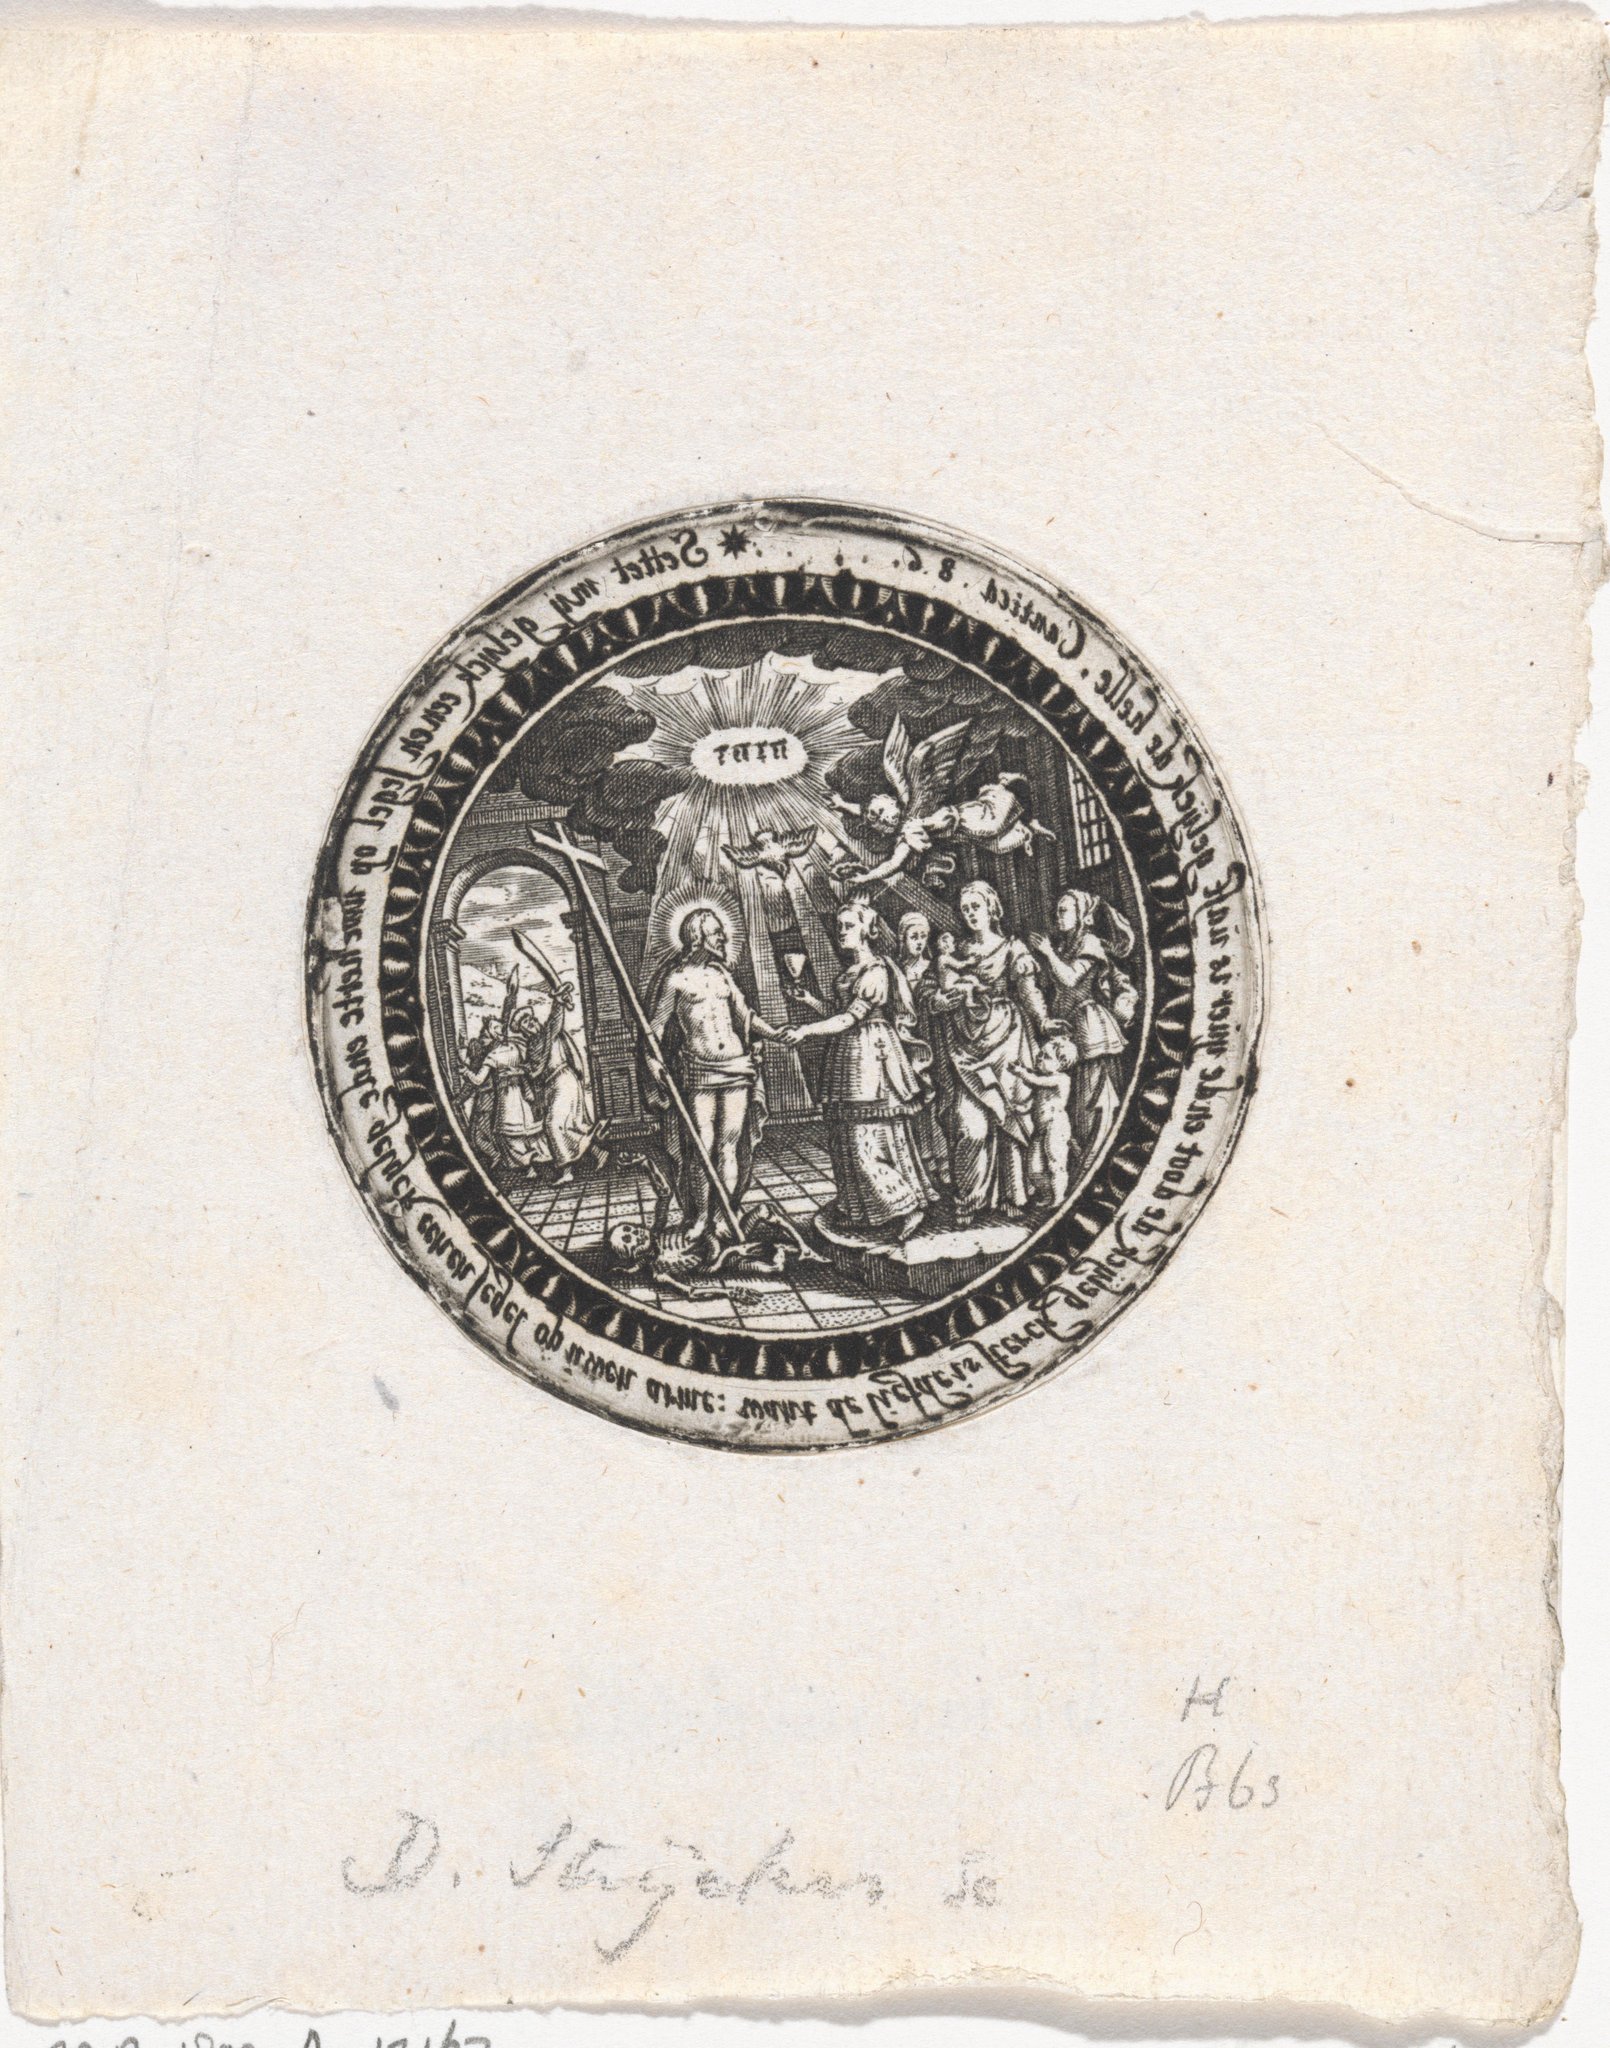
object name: print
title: Afdruk van een medaillon met een voorstelling van het huwelijk van Christus met zijn kerk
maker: dirck strijcker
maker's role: draughtsman, print maker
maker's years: 1588-1677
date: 1607-1677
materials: paper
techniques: engraving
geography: amsterdam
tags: 'ecclesia' as bride of christ (the lamb), 'ecclesia sponsa dei', 'sponsus-sponsa', the three theological virtues, tetragram (in roman or hebrew script) ~ symbol of god the father, holy ghost represented as a dove (in flames)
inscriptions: collector's mark: Lugt 2228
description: Afdruk van een medaillon. Voorstelling van het huwelijk tussen Christus en de Kerk (Ecclesia). Boven hun hoofde de duif van de Heilige Geest en het tetragram als symbool van God de Vader. Ecclesia houdt een kelk in haar hand en achter haar staan Geloof, Hoop en Liefde. Christus houdt het kruis in zijn hand en staat op een geraamte ten teken van zijn overwinning op de dood. In het randschrift een Bijbelvers in spiegelbeeld uit Hoogl. 8:6.